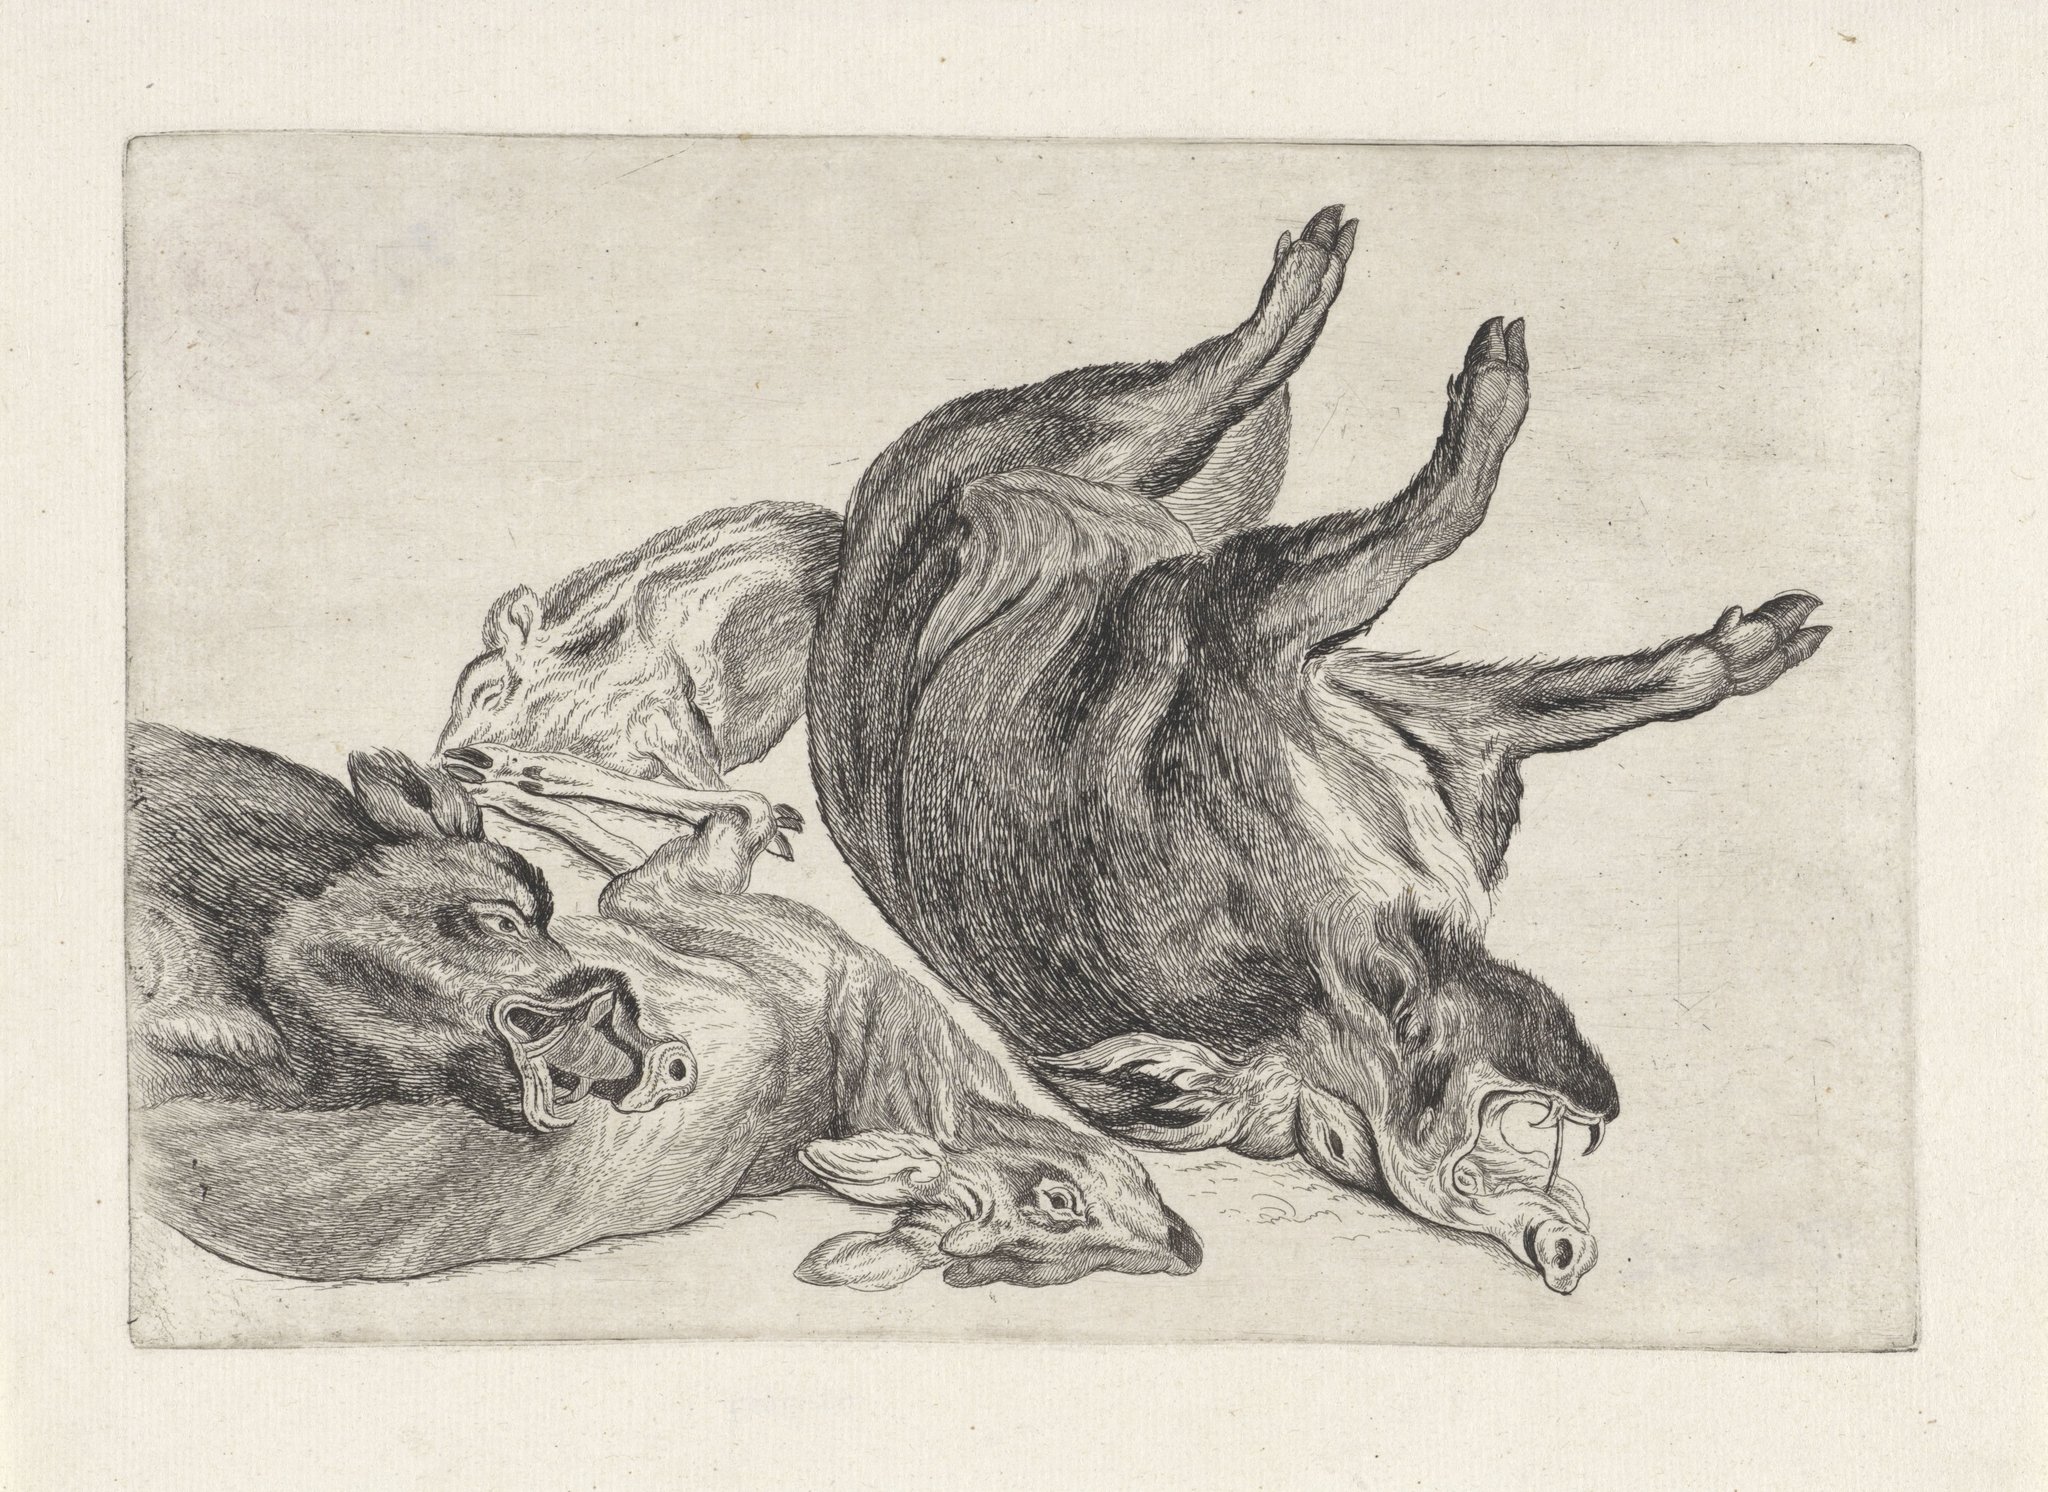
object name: print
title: Geschoten wild: een dood hert en wilde zwijnen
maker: wenceslaus hollar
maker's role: draughtsman, print maker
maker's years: 1607-1677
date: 1646-1647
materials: paper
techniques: etching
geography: antwerp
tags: hoofed animals: deer, hoofed animals: boar, spoils of the hunt, game, venison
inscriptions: collector's mark: Lugt 240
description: Prent uit twintigdelige serie (incl. titelprent) met voorstellingen over de jacht: "Jacht, jachthonden en wild".